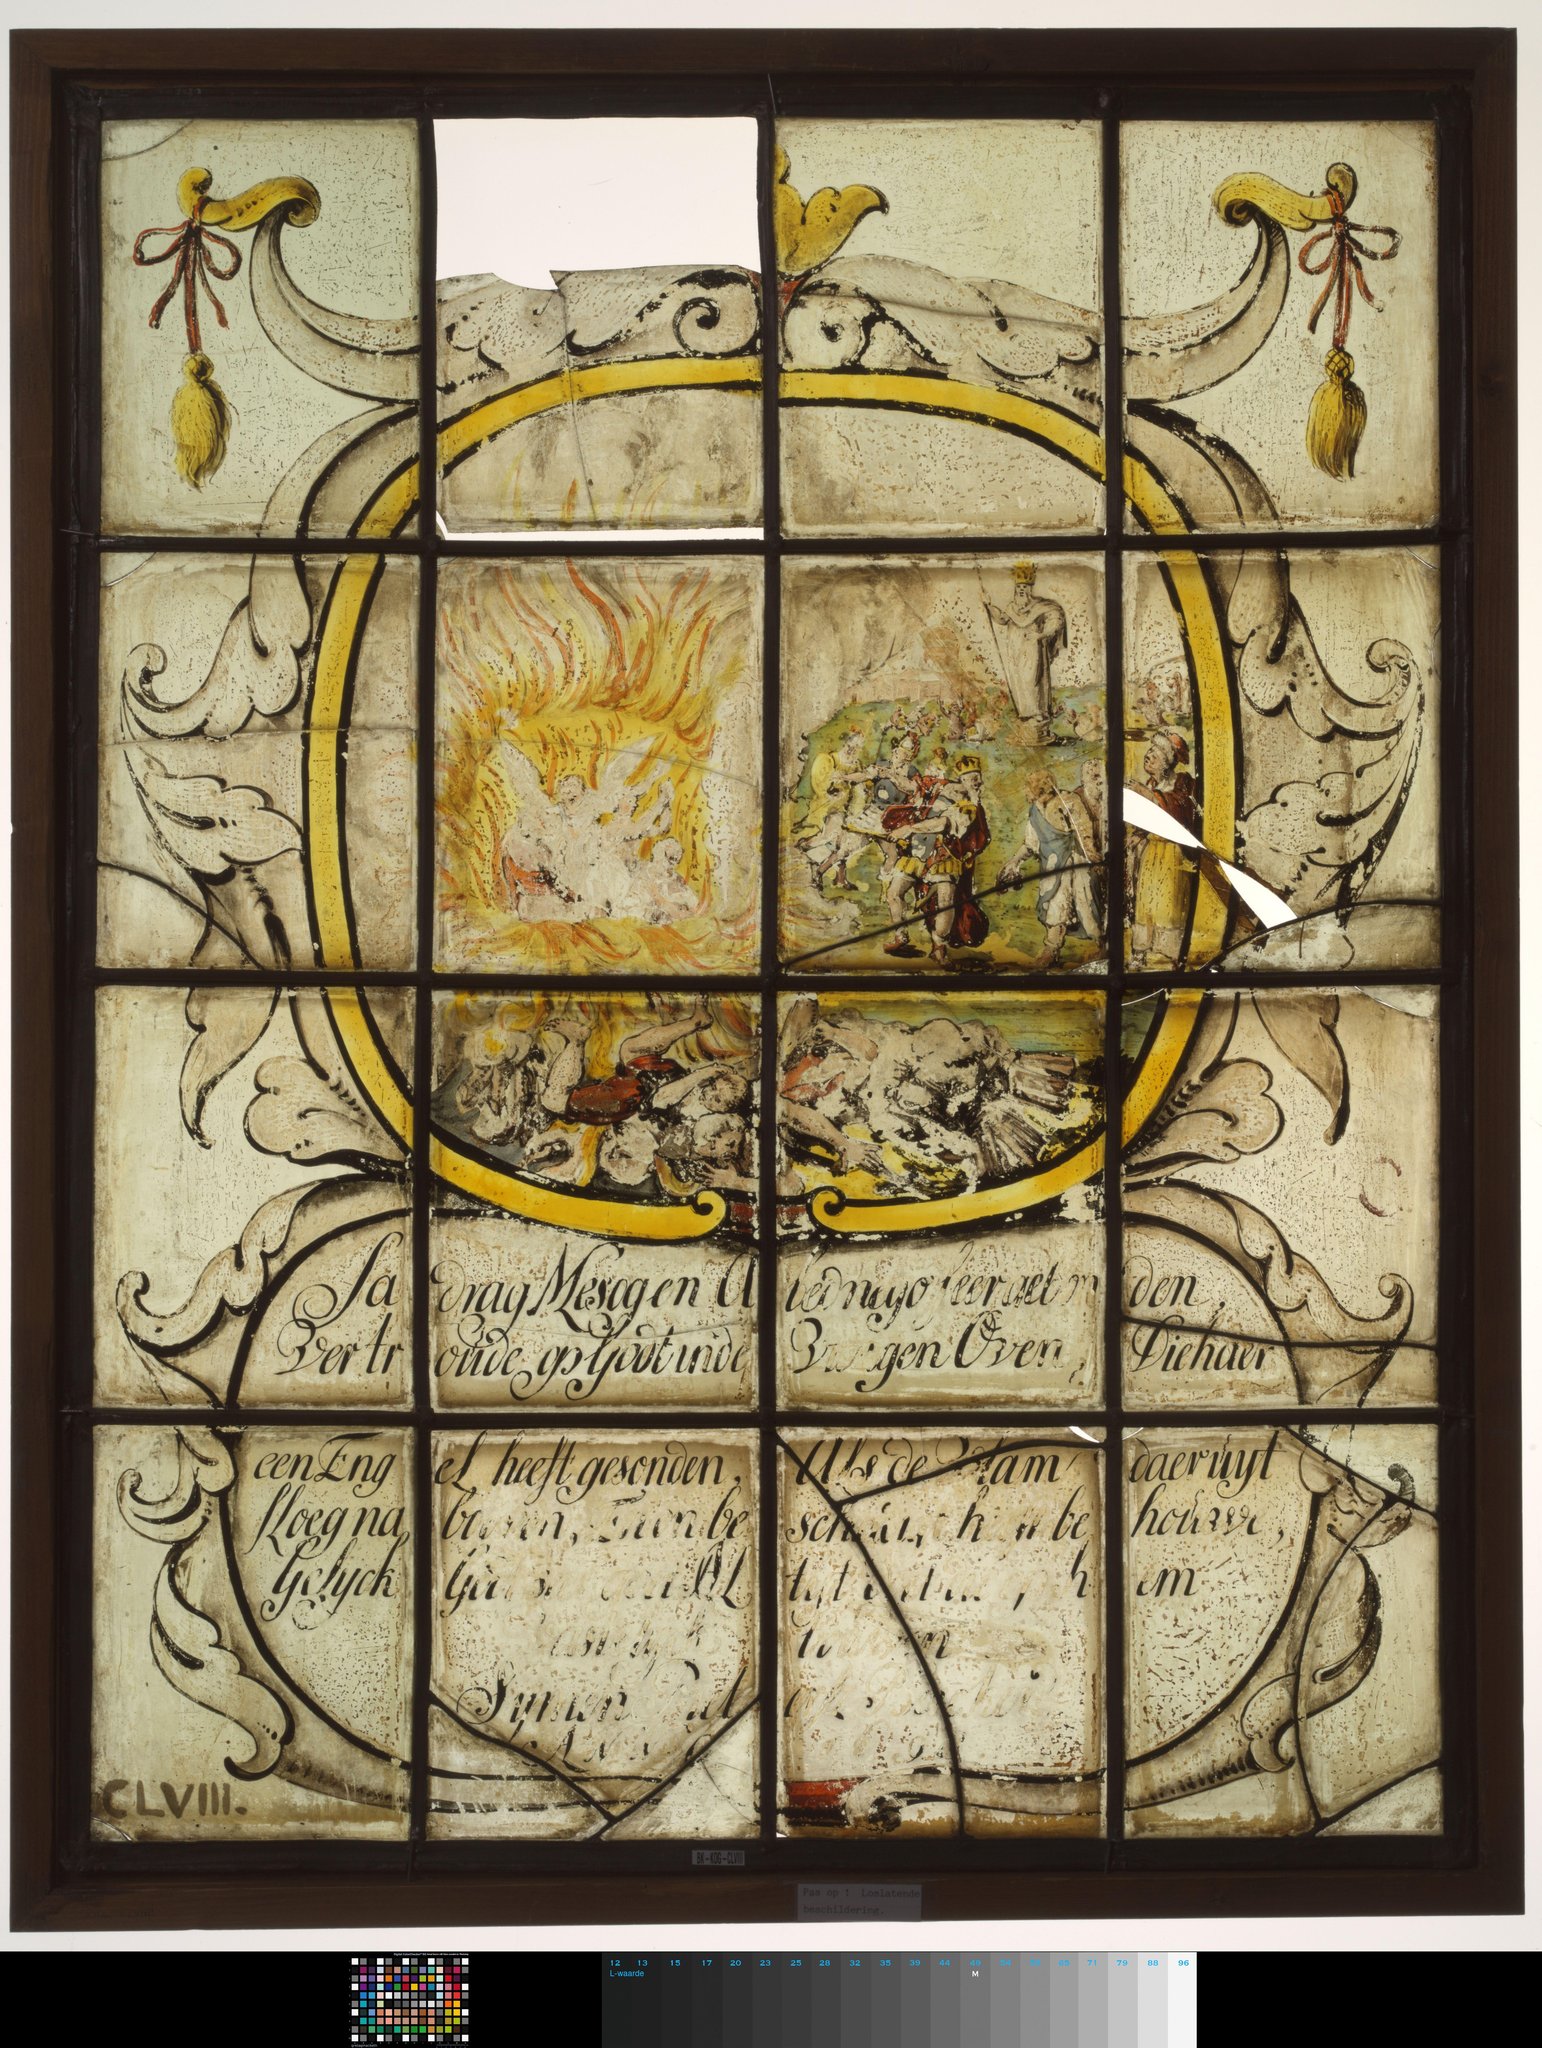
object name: light window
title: Ruit met de drie jongelingen in oven waaronder cartouche met vers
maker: Anonymous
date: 1690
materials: glass, lead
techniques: leading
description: Ruit met bijbelse voorstelling t.w. de drie jongelingen in de oven, waaronder een cartouche met een vers.